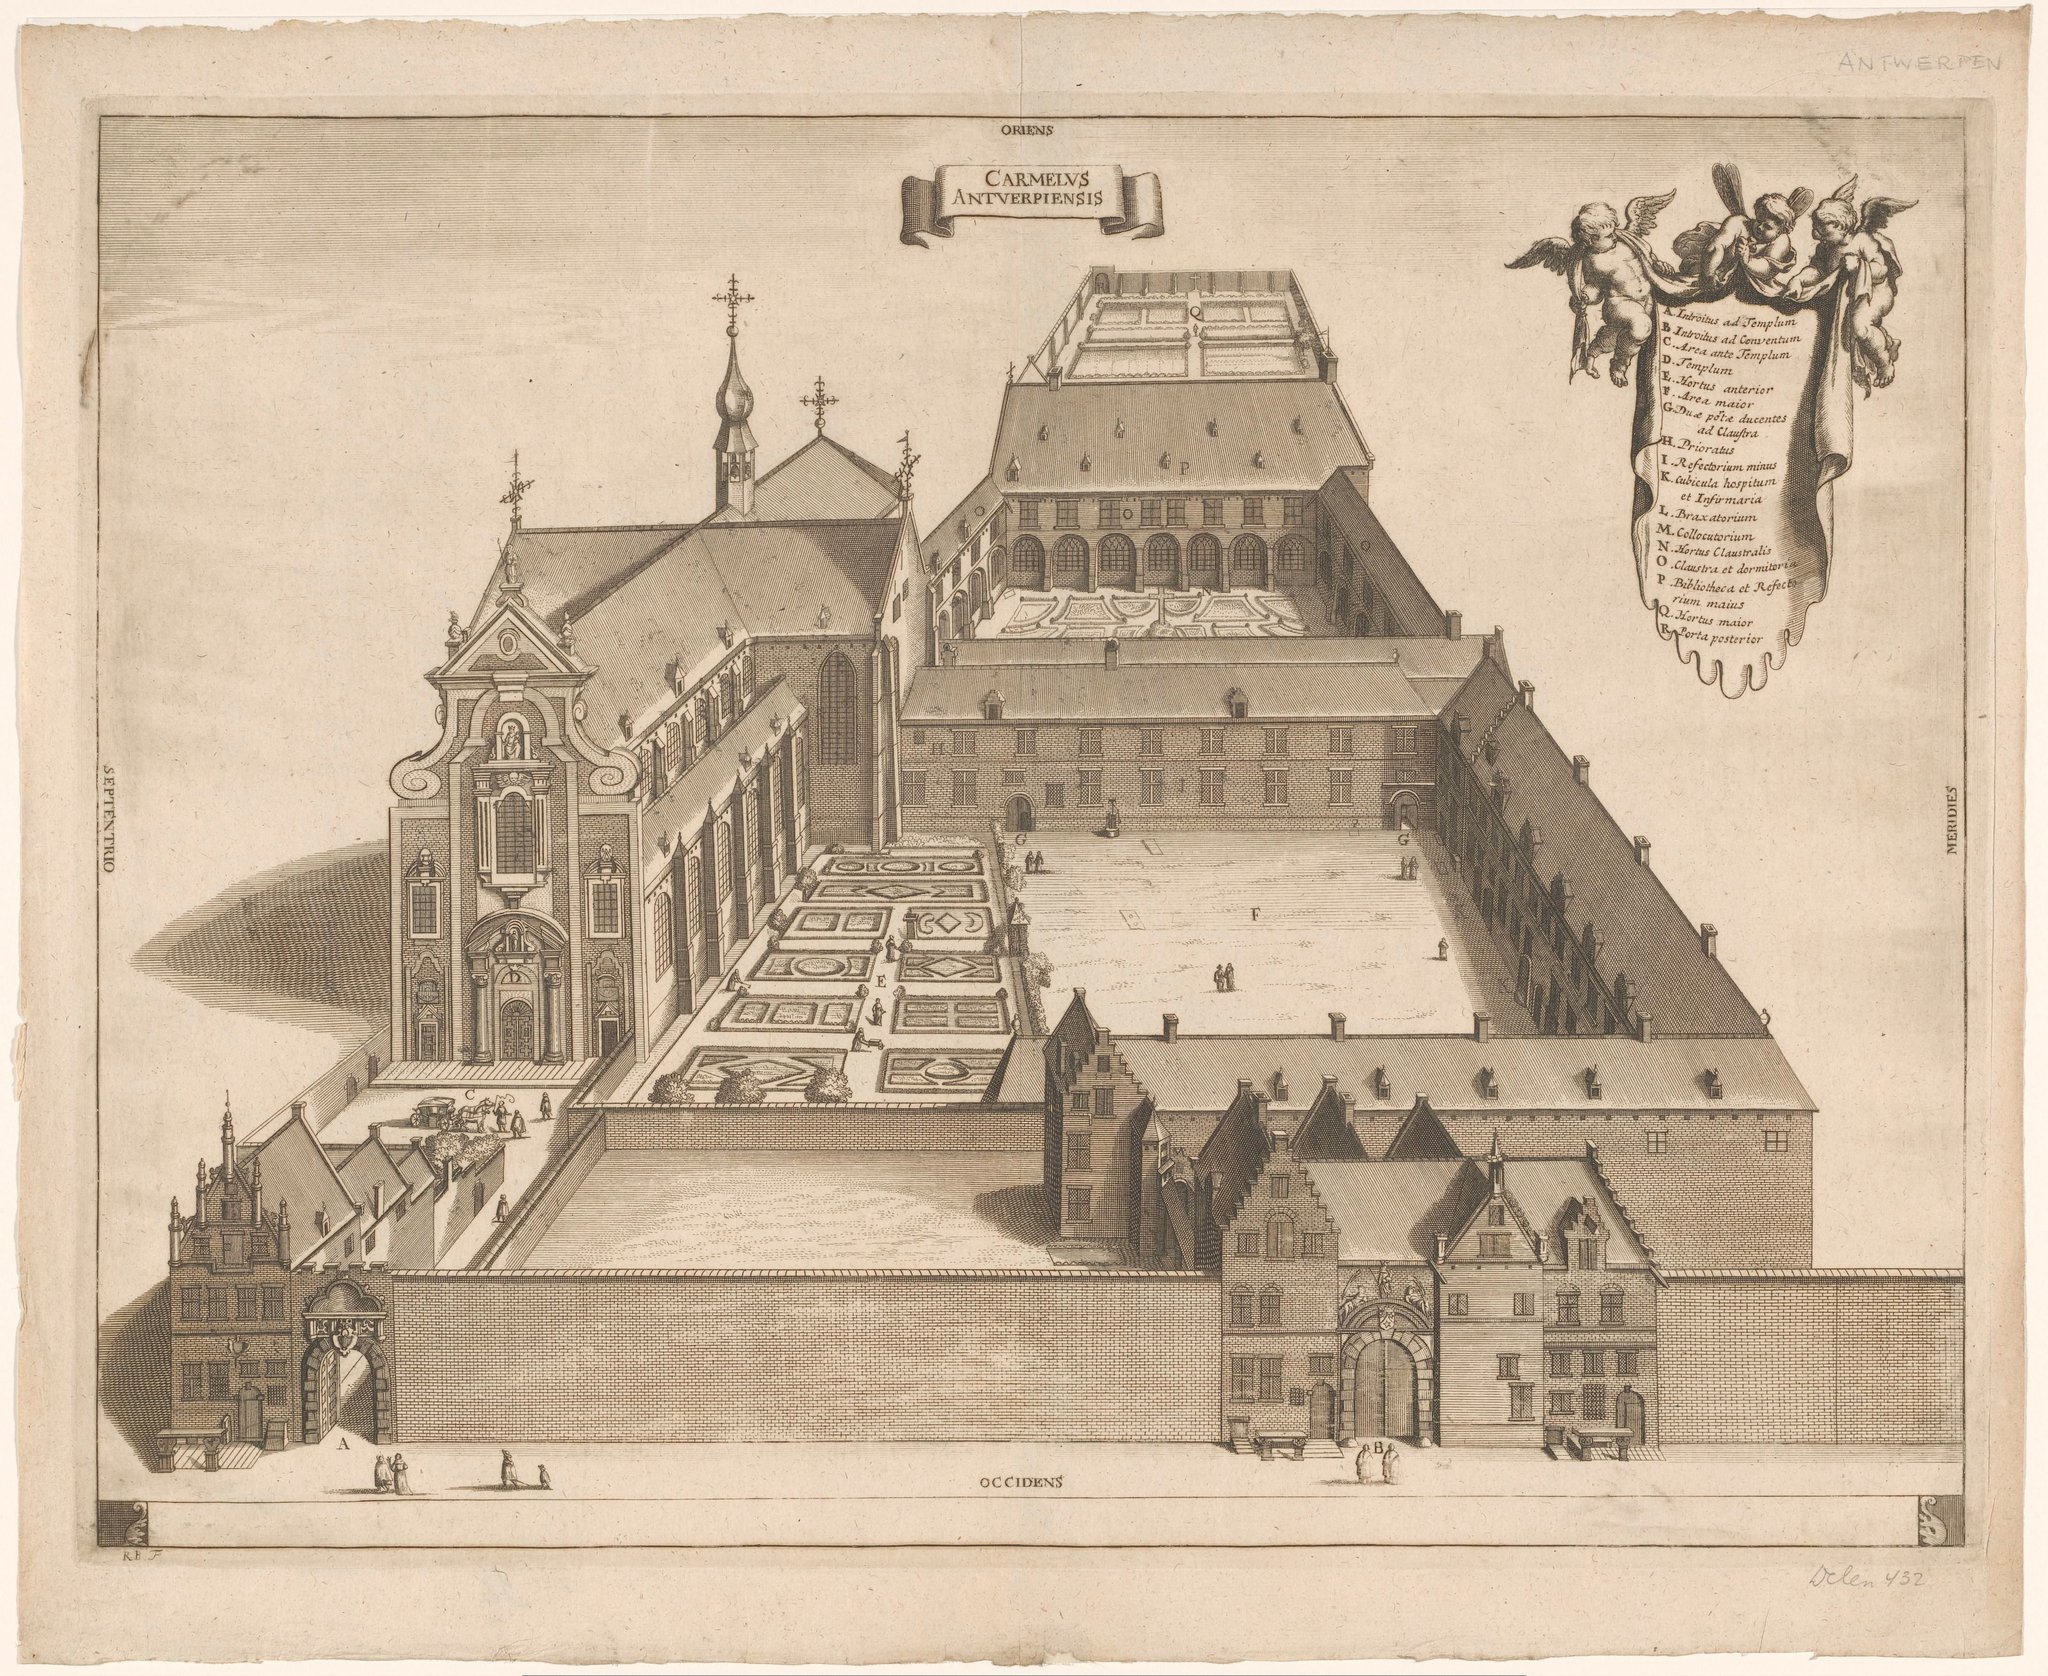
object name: book illustration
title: Carmelus Antverpiensis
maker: reynier blokhuysen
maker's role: print maker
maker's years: 1663-1744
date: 1727-1734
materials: paper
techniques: engraving, etching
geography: leiden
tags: church (exterior), cloisters ~ monastery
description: Prent ook gebruikt in: Sanderus, Antonius. Groot kerkelyk toneel des Hertogdoms van Brabant (...). Den Haag: Christiaan van Lom, 1727. En in: Sanderus, Antonius. Antonii Sanderi presbyteri Chorographia sacra Brabantiæ. 3 delen. Den Haag: Christiaan van Lom, 1726-1727, dl. 2 (1727). En in: Sanderus, Antonius. Le grand theatre sacré du duché de Brabant (...). 4 delen. Den Haag: Gerard Block, 1729-1734.